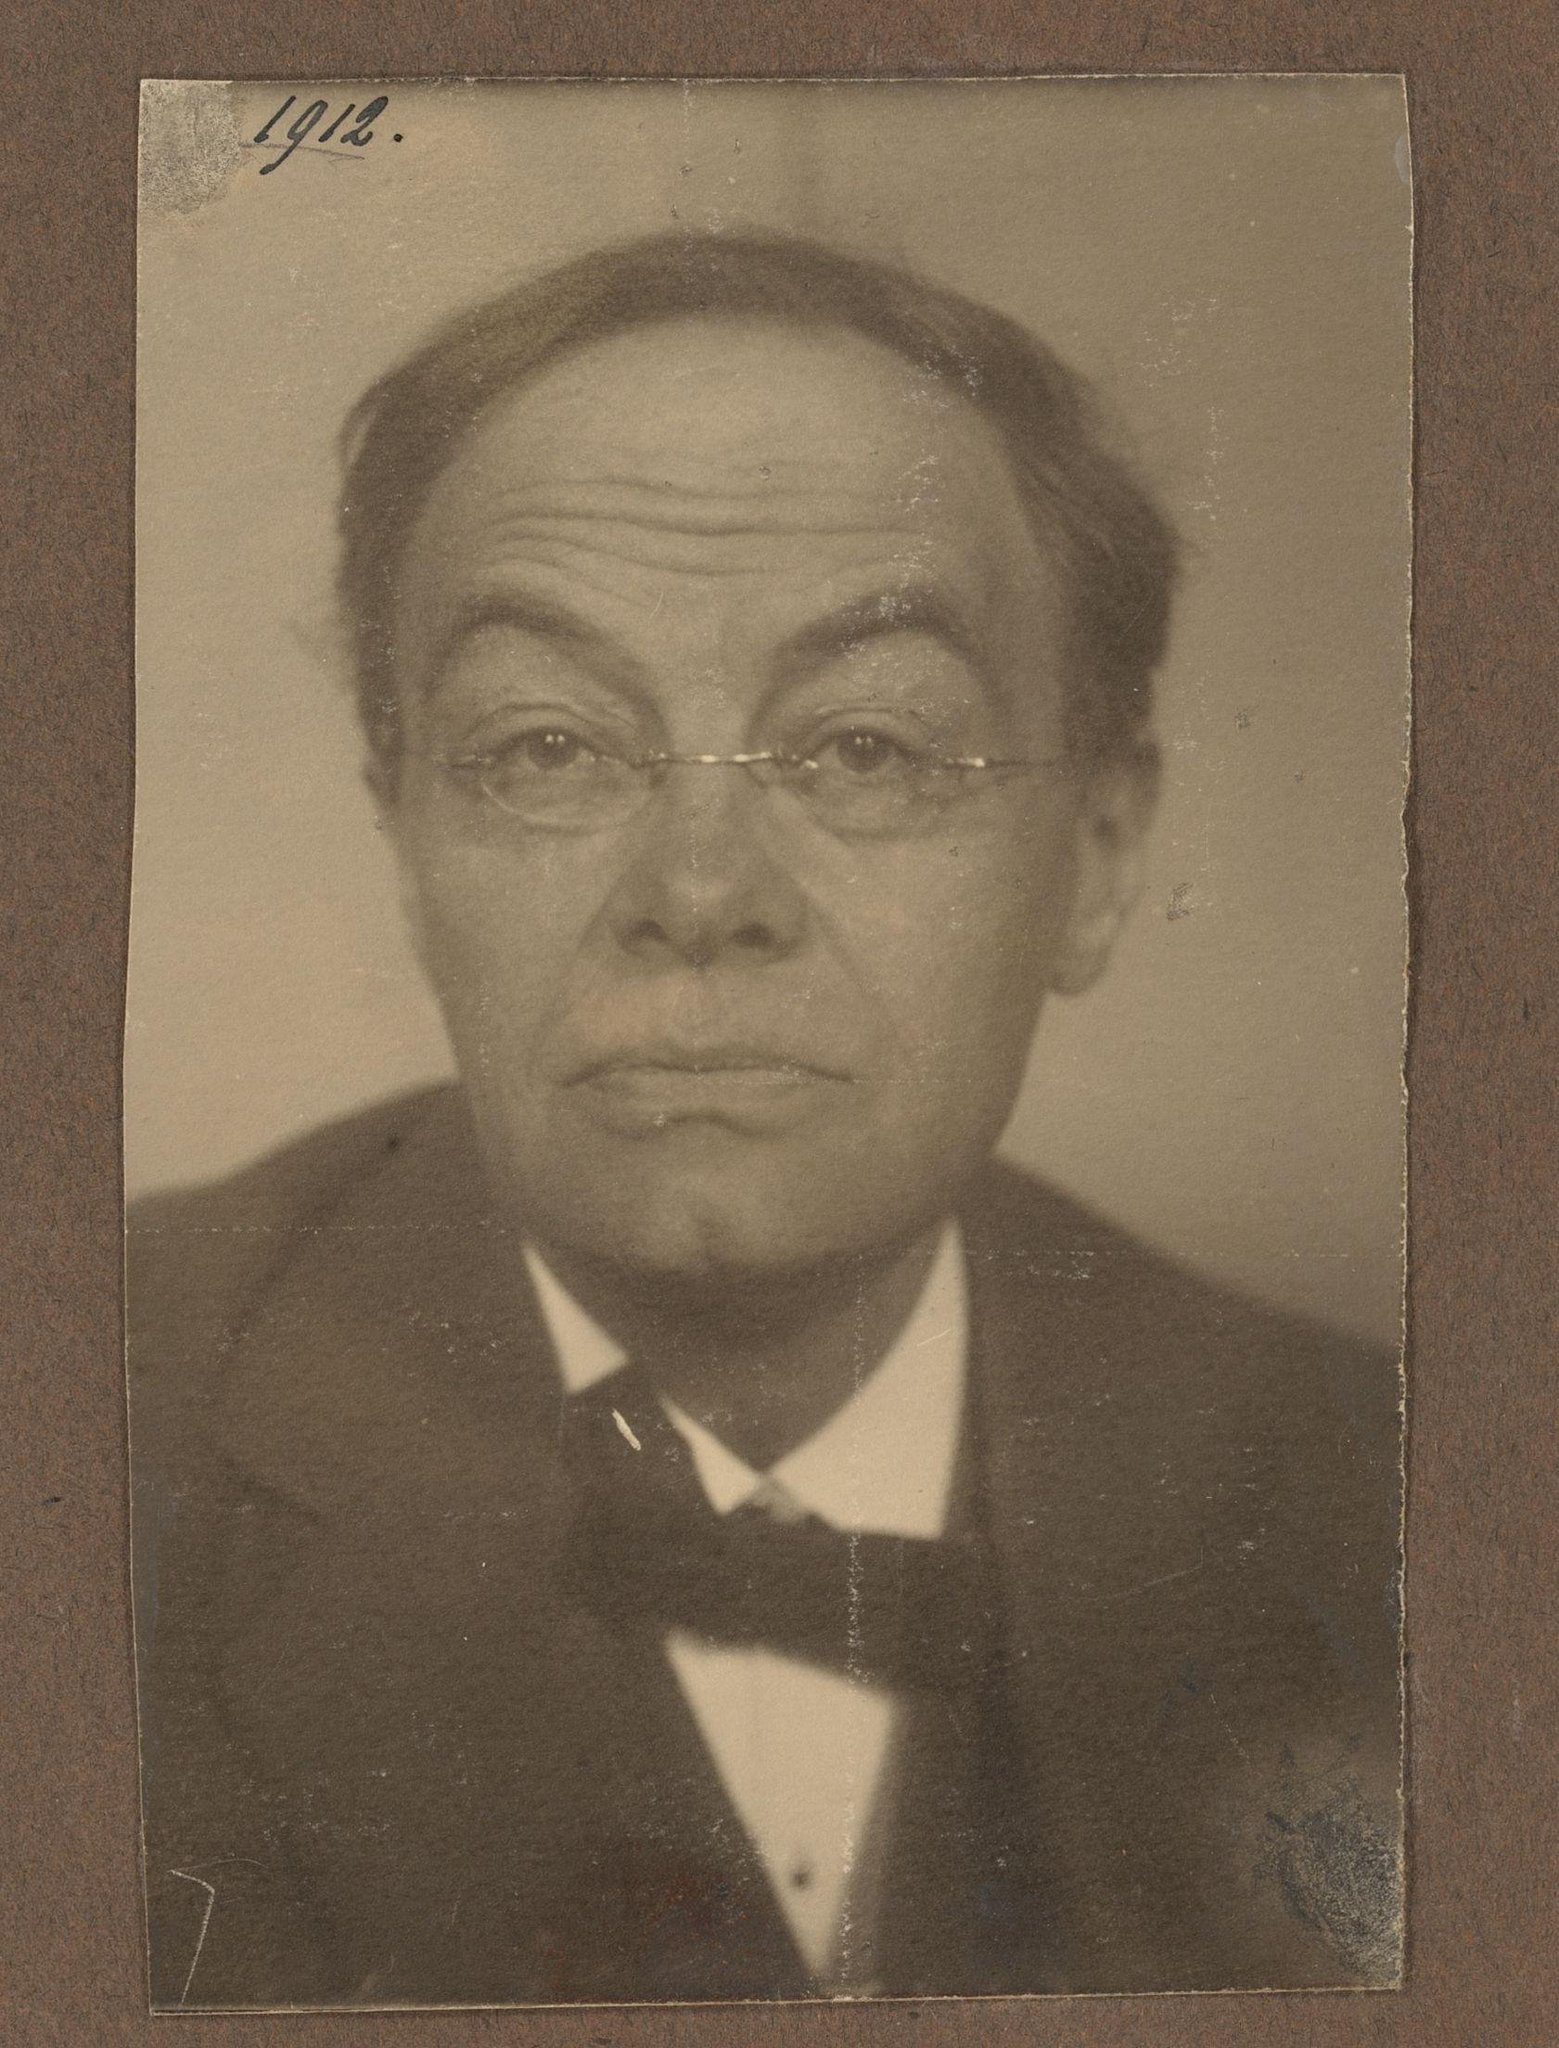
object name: photograph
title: Portret van Alphons Diepenbrock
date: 1911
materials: photographic support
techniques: daylight paper print, pasting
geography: amsterdam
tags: amsterdam, alphons diepenbrock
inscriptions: date: ‘1912.’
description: Foto op bruin albumblad 10 van familiealbum van Alphons Diepenbrock.